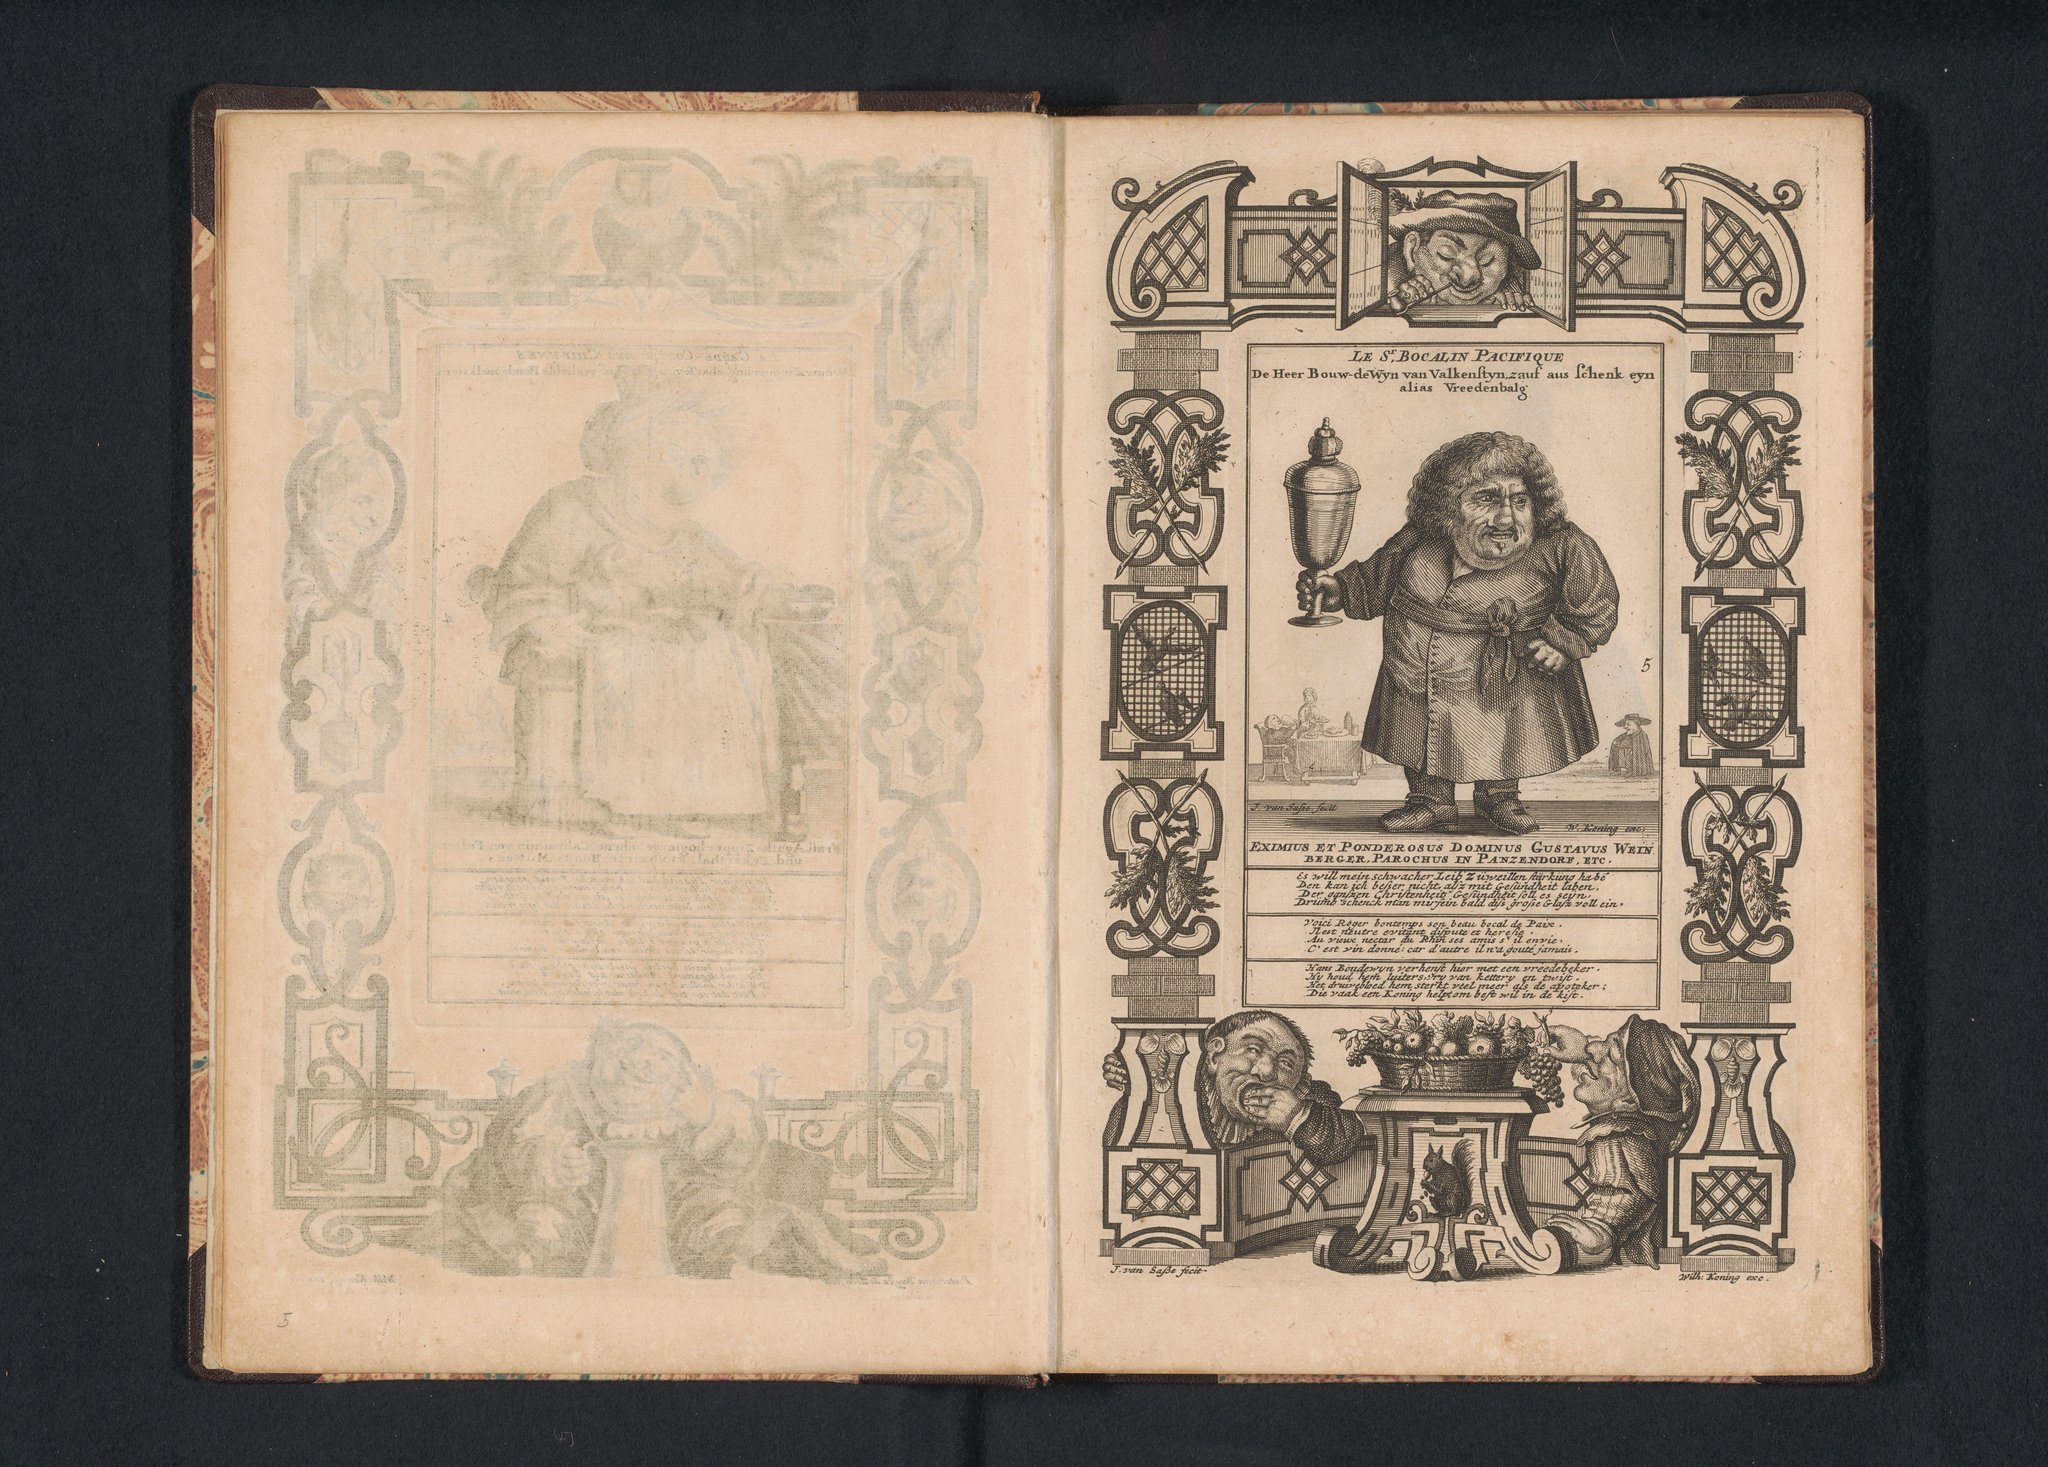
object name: caricature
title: De dwerg Bouw-deWyn van Valkenstyn als een geestelijke met een beker, 1716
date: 1716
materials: paper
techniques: etching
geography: amsterdam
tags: caricatures (human types), little people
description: De kleine mens Bouw-deWyn van Valkenstyn als een geestelijke met een gouden beker. In het onderschrift verzen in het Duits, Frans en Nederlands. Afdruk binnen een decoratieve omlijsting gedrukt van een aparte plaat met onderaan twee kleine mensen bij een fruitmand. Genummerd rechts midden: 5. Onderdeel van de Nederlandse gebonden uitgave uit 1716 van een serie karikaturen van kleine mensen, bekend als Het Dwergentooneel, gekopieerd naar een ouder Duits voorbeeld.